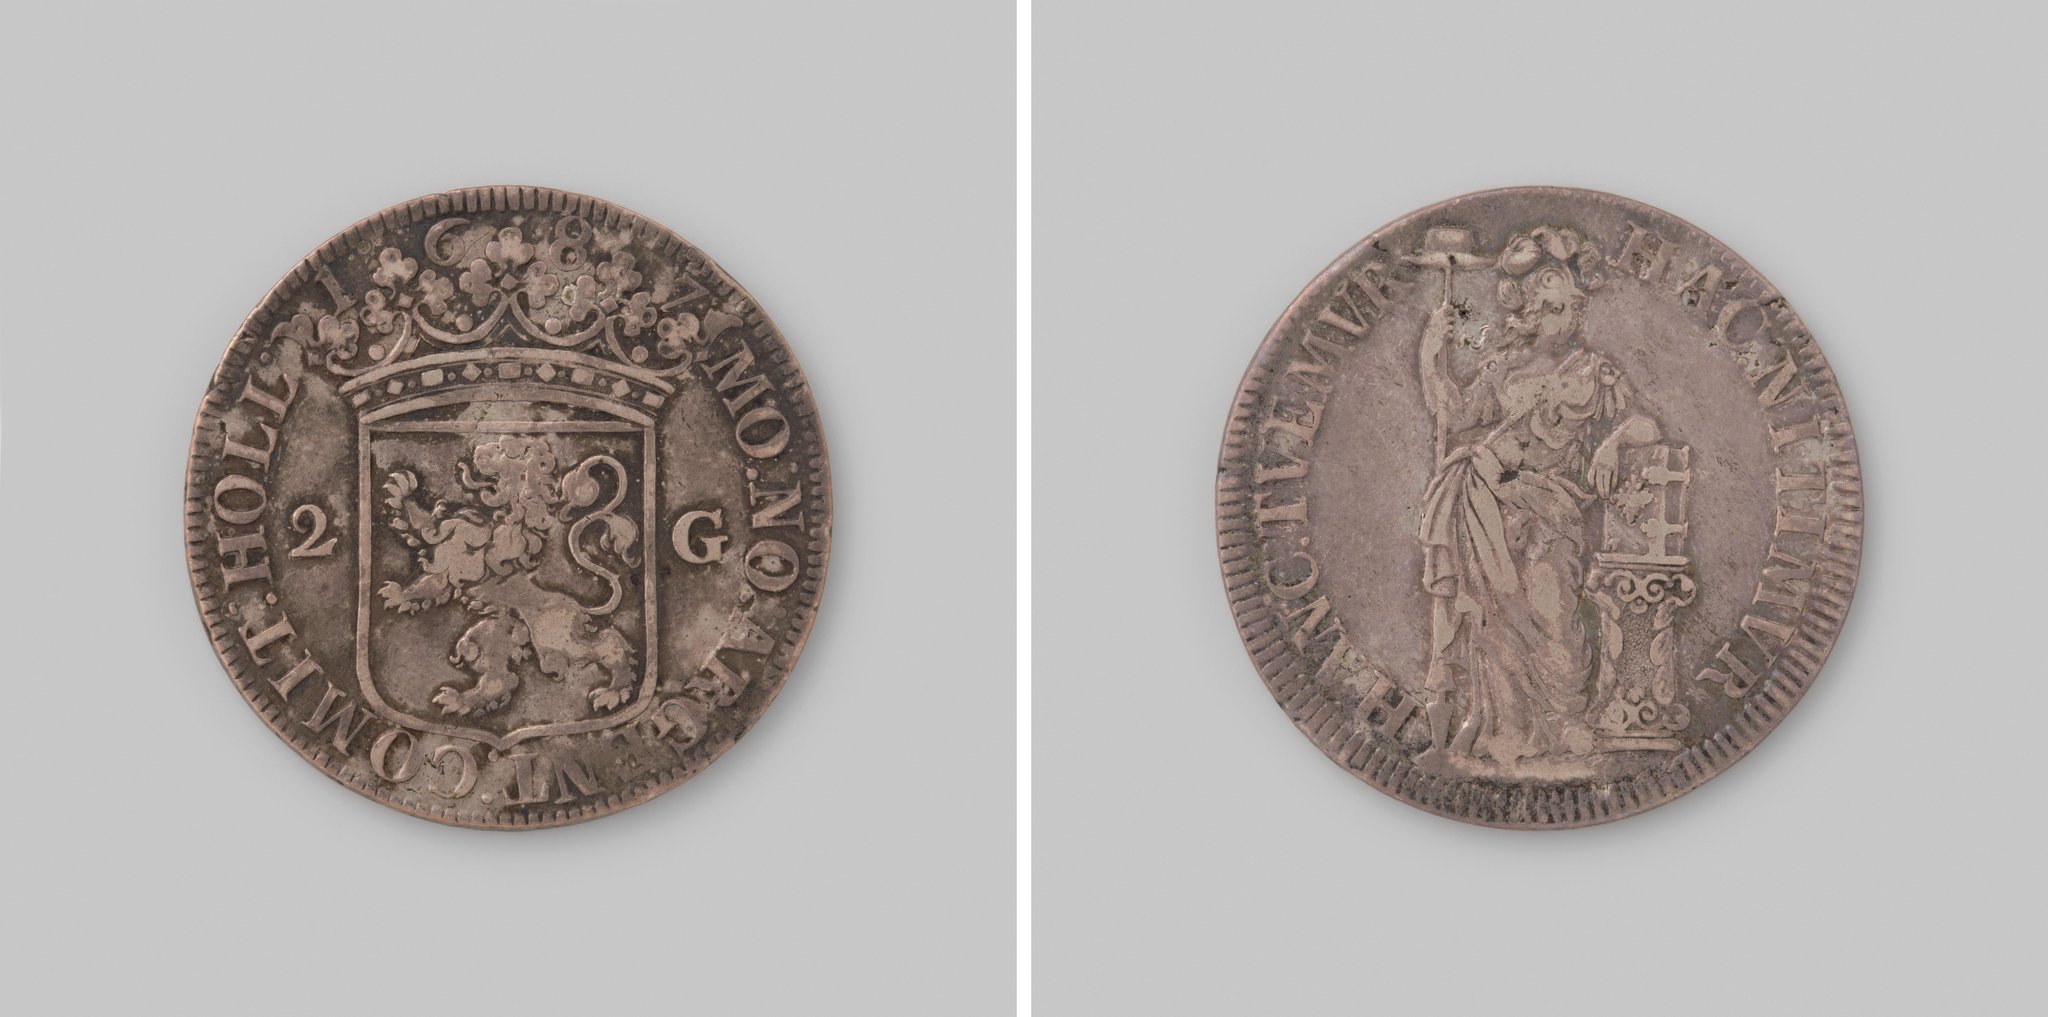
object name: coin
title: Holland, provinciale twee gulden, 1687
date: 1687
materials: silver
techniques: striking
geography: dordrecht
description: Zilveren munt. Voorzijde: gekroond wapenschild van Holland. Boven kroon jaartal. Keerzijde: staande Nederlandse maagd met in rechterhand speer, waarop hoed en met linkerhand steunend op altaar, waarop bijlbel.